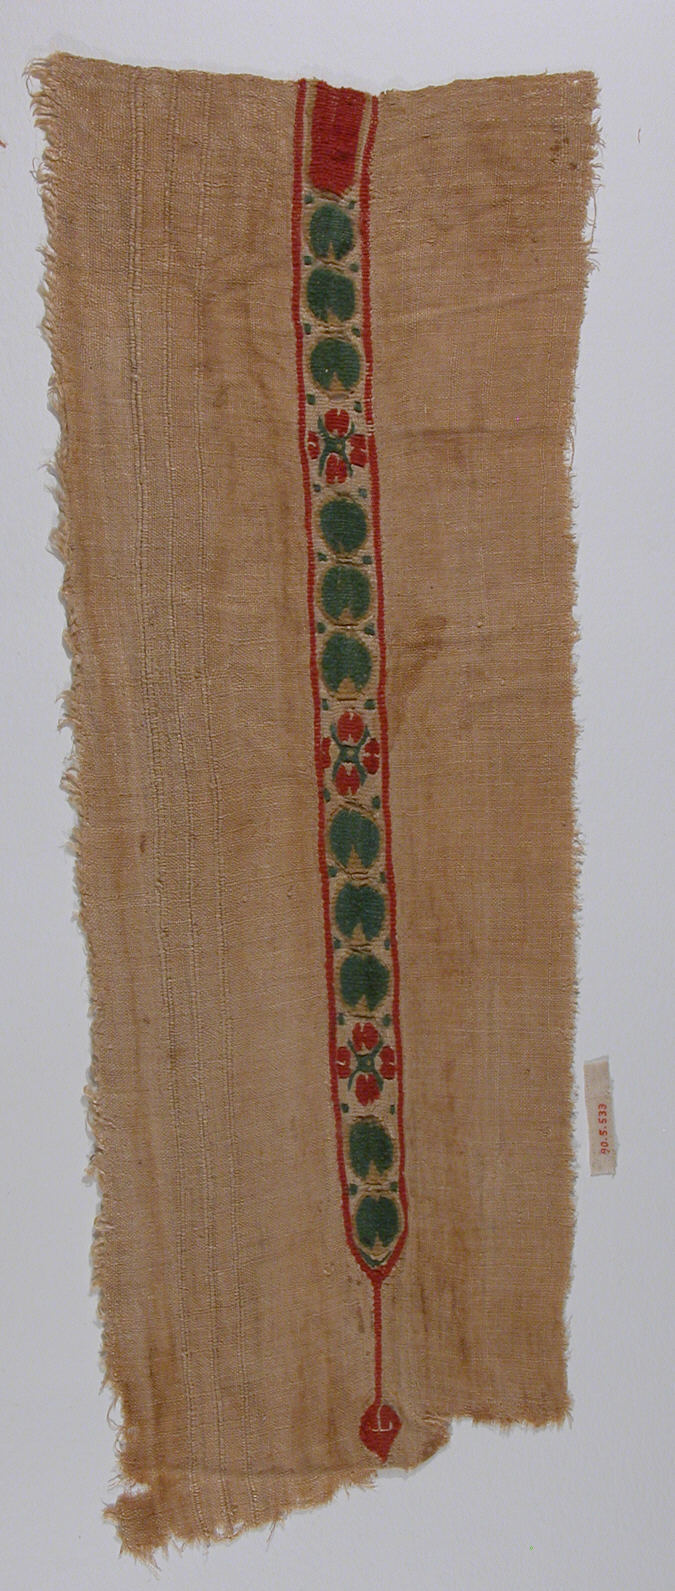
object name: textile fragment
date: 301-500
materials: linen, wool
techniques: weave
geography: egypt